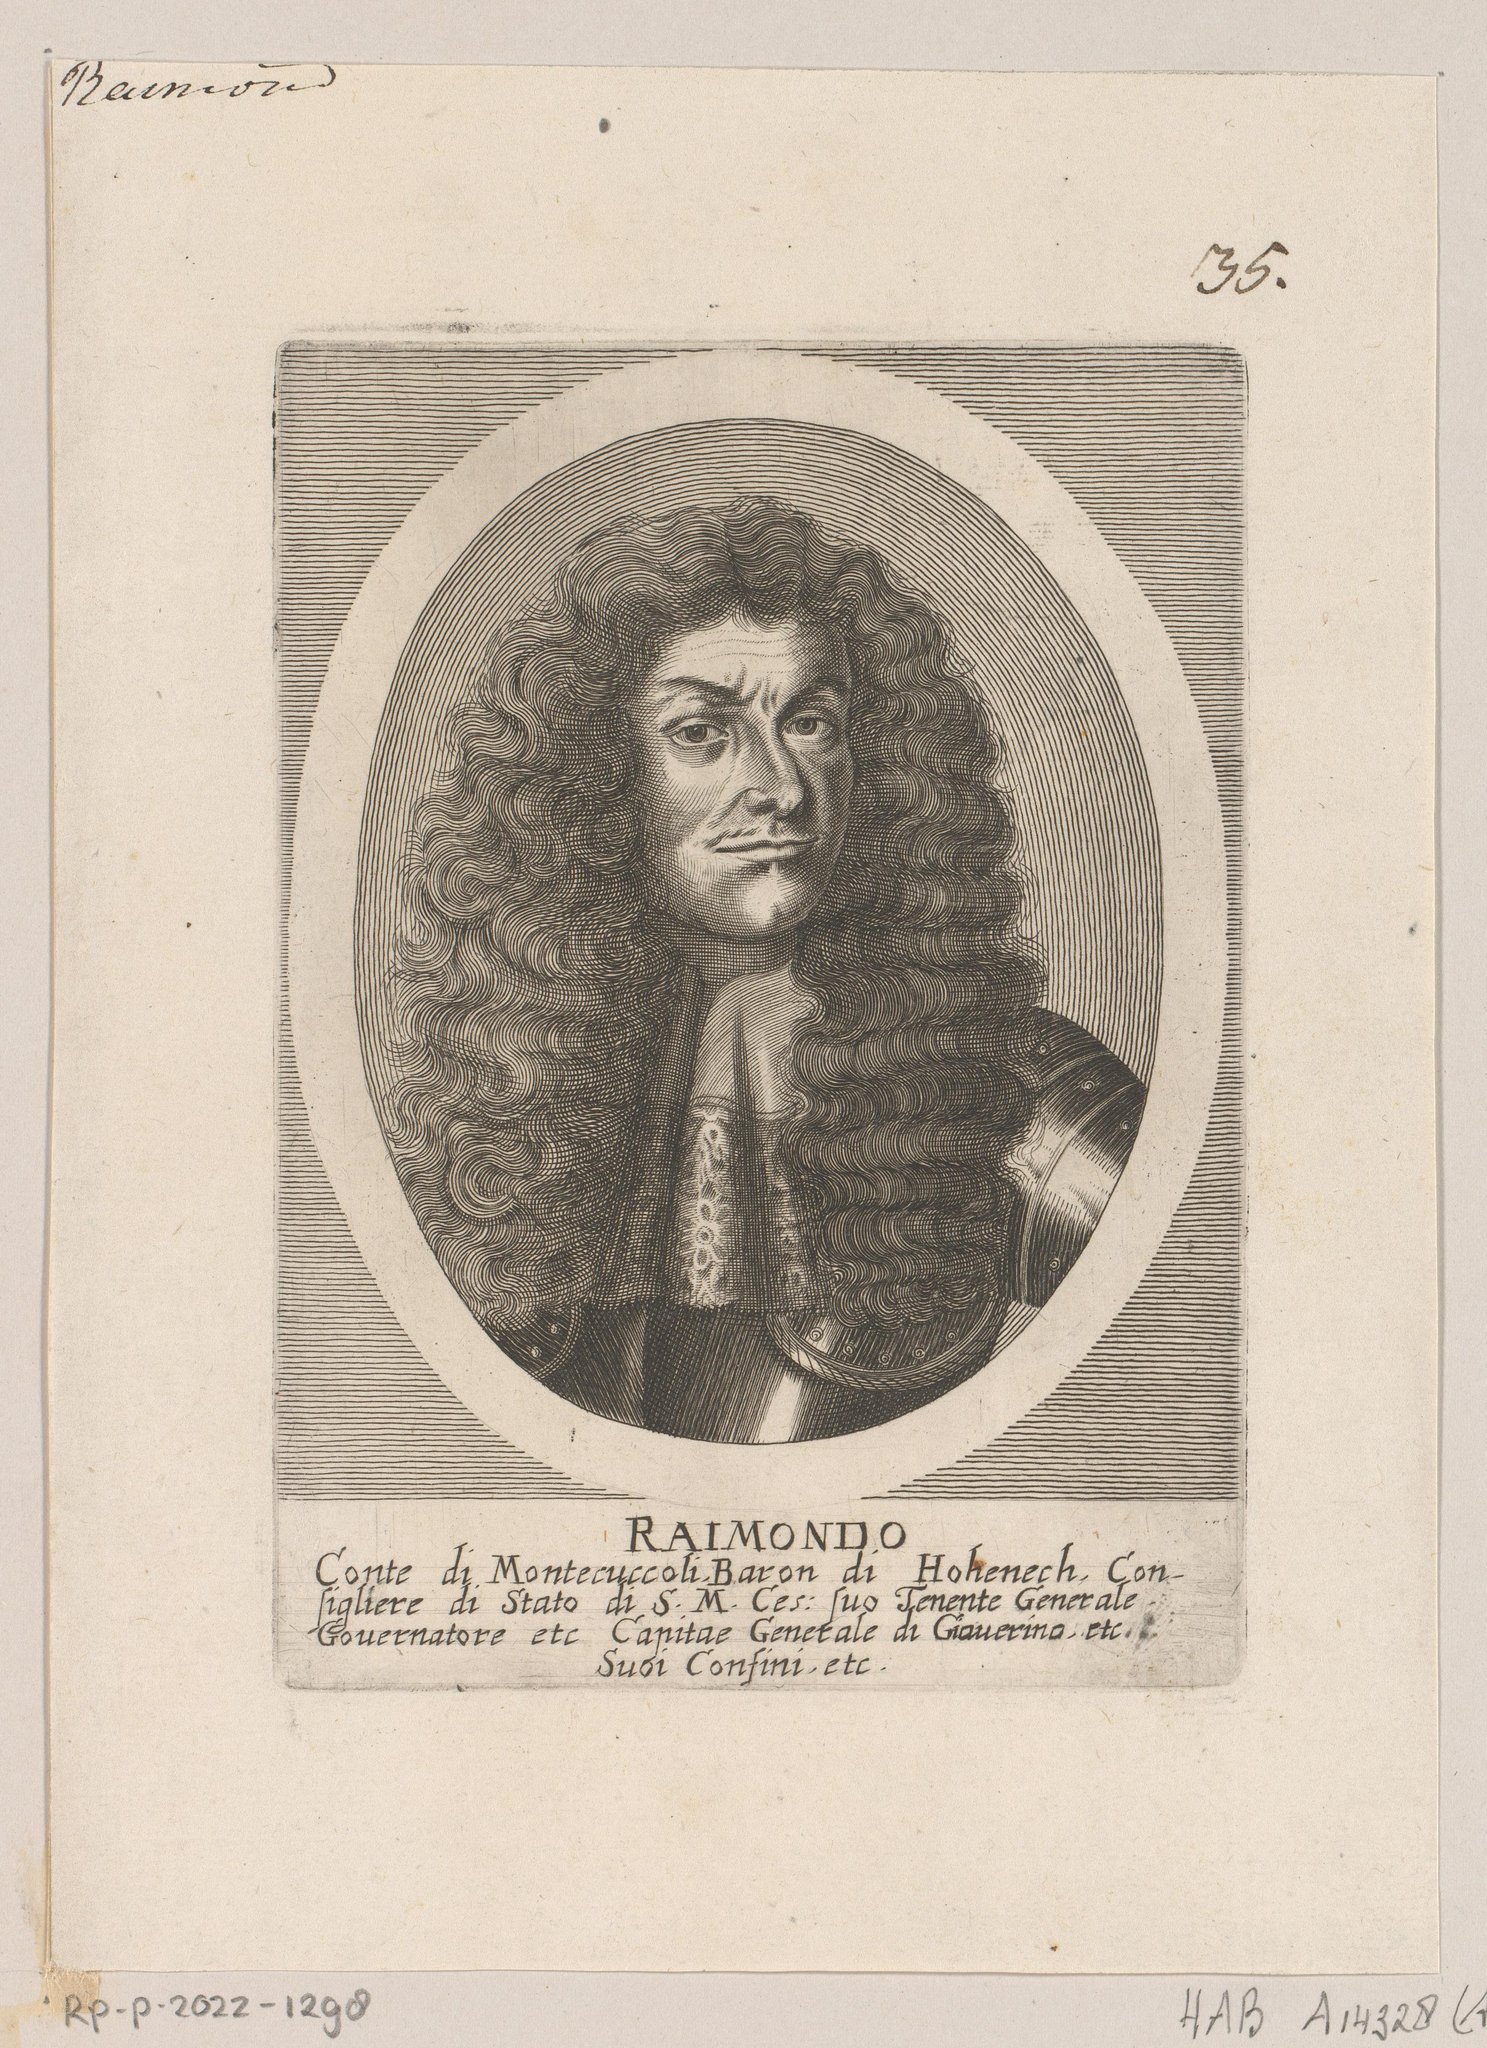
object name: book illustration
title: Portret van Raimondo Montecuccoli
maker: Anonymous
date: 1672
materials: paper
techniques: engraving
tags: commander-in-chief, general, marshal, historical persons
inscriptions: number: ‘35.’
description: Prent waarschijnlijk uit: Meyer,Martin. Der Historisch-fortgeführten Friedens- und Kriegs-Beschreibung. Frankfurt am Main: Matthaeus Merian, 1672.